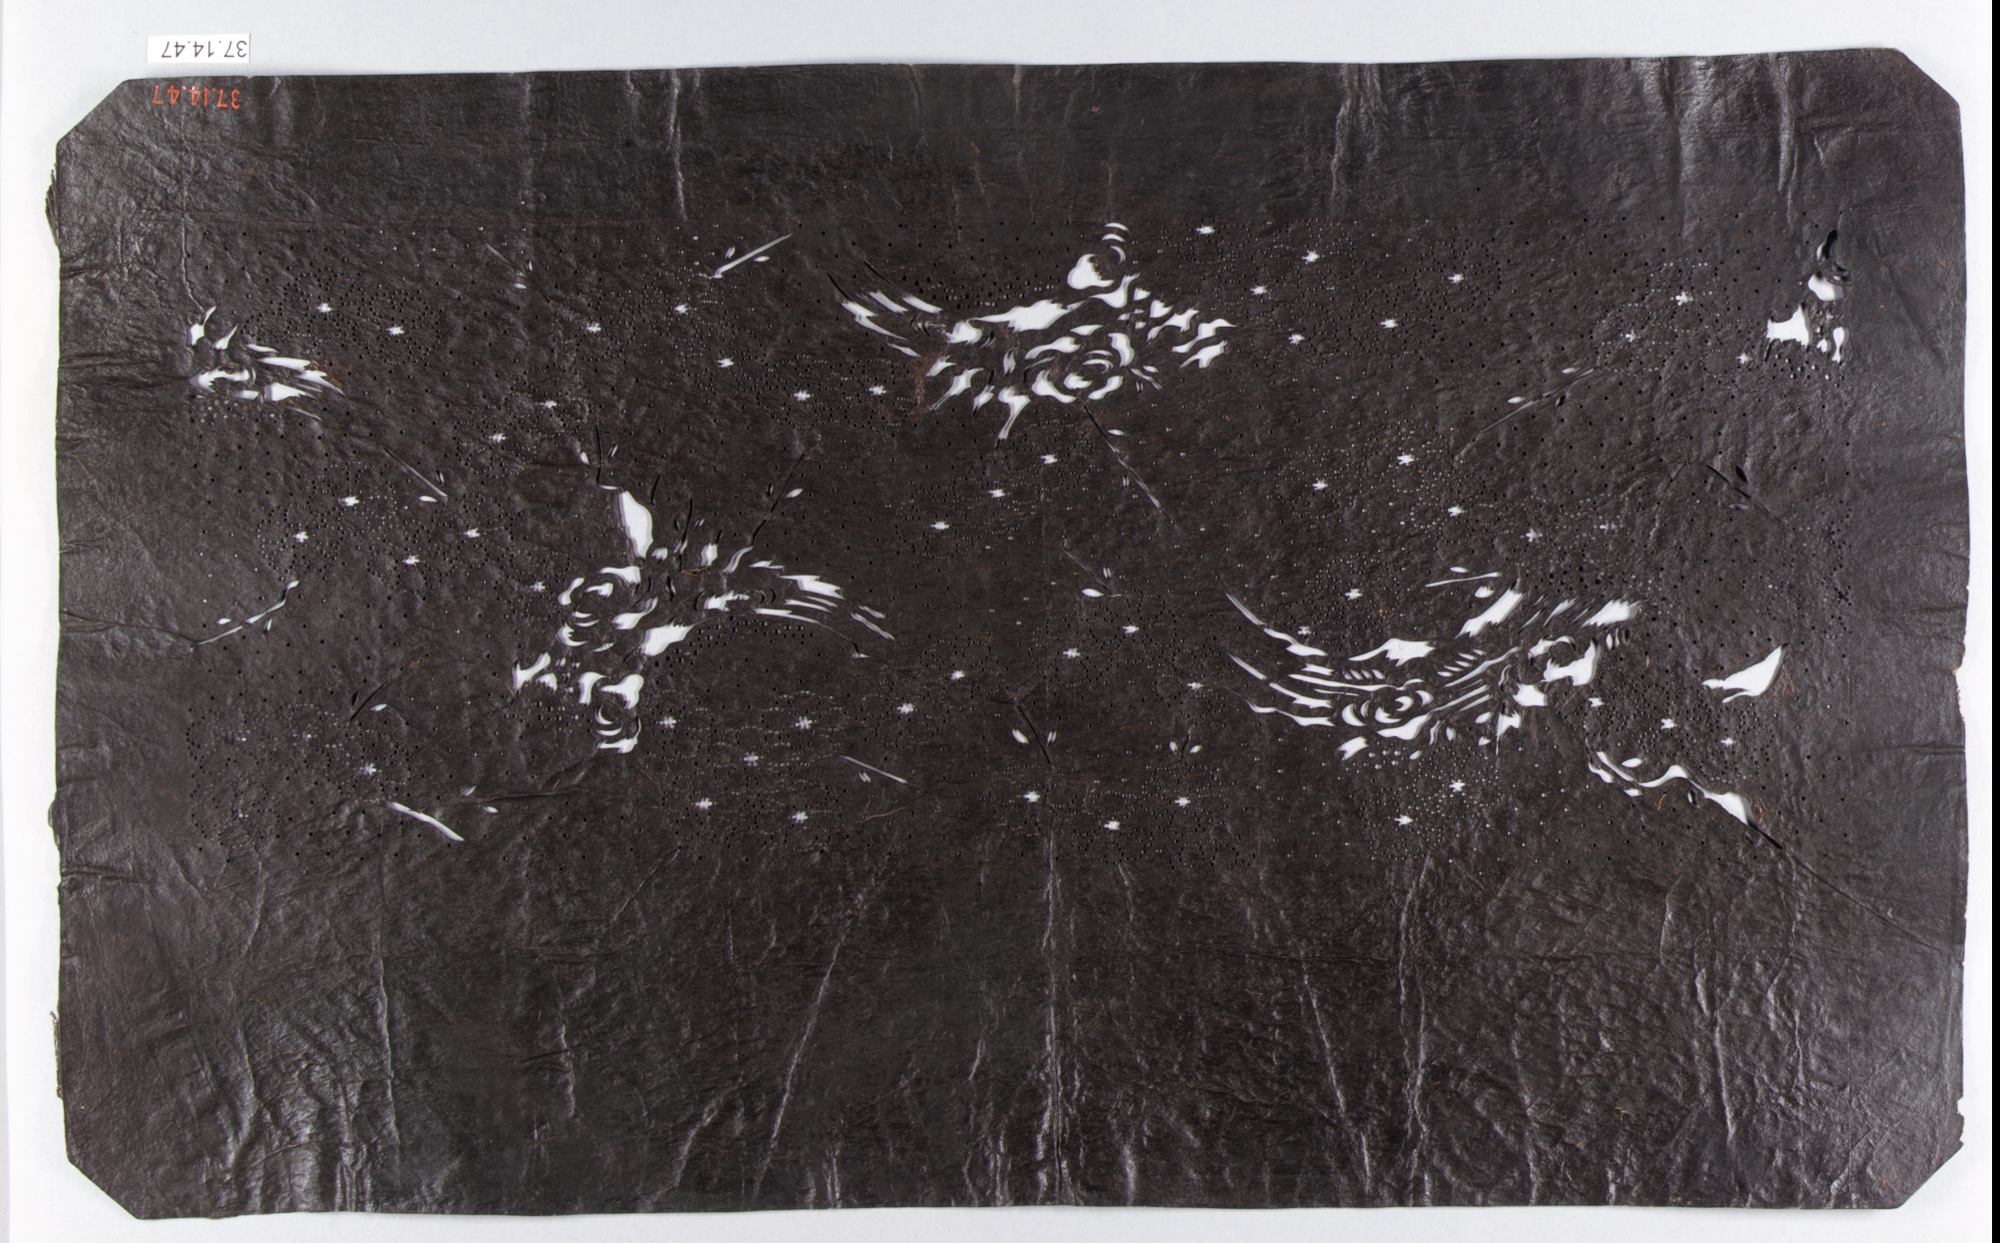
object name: stencil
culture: japanese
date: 1801-1833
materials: paper